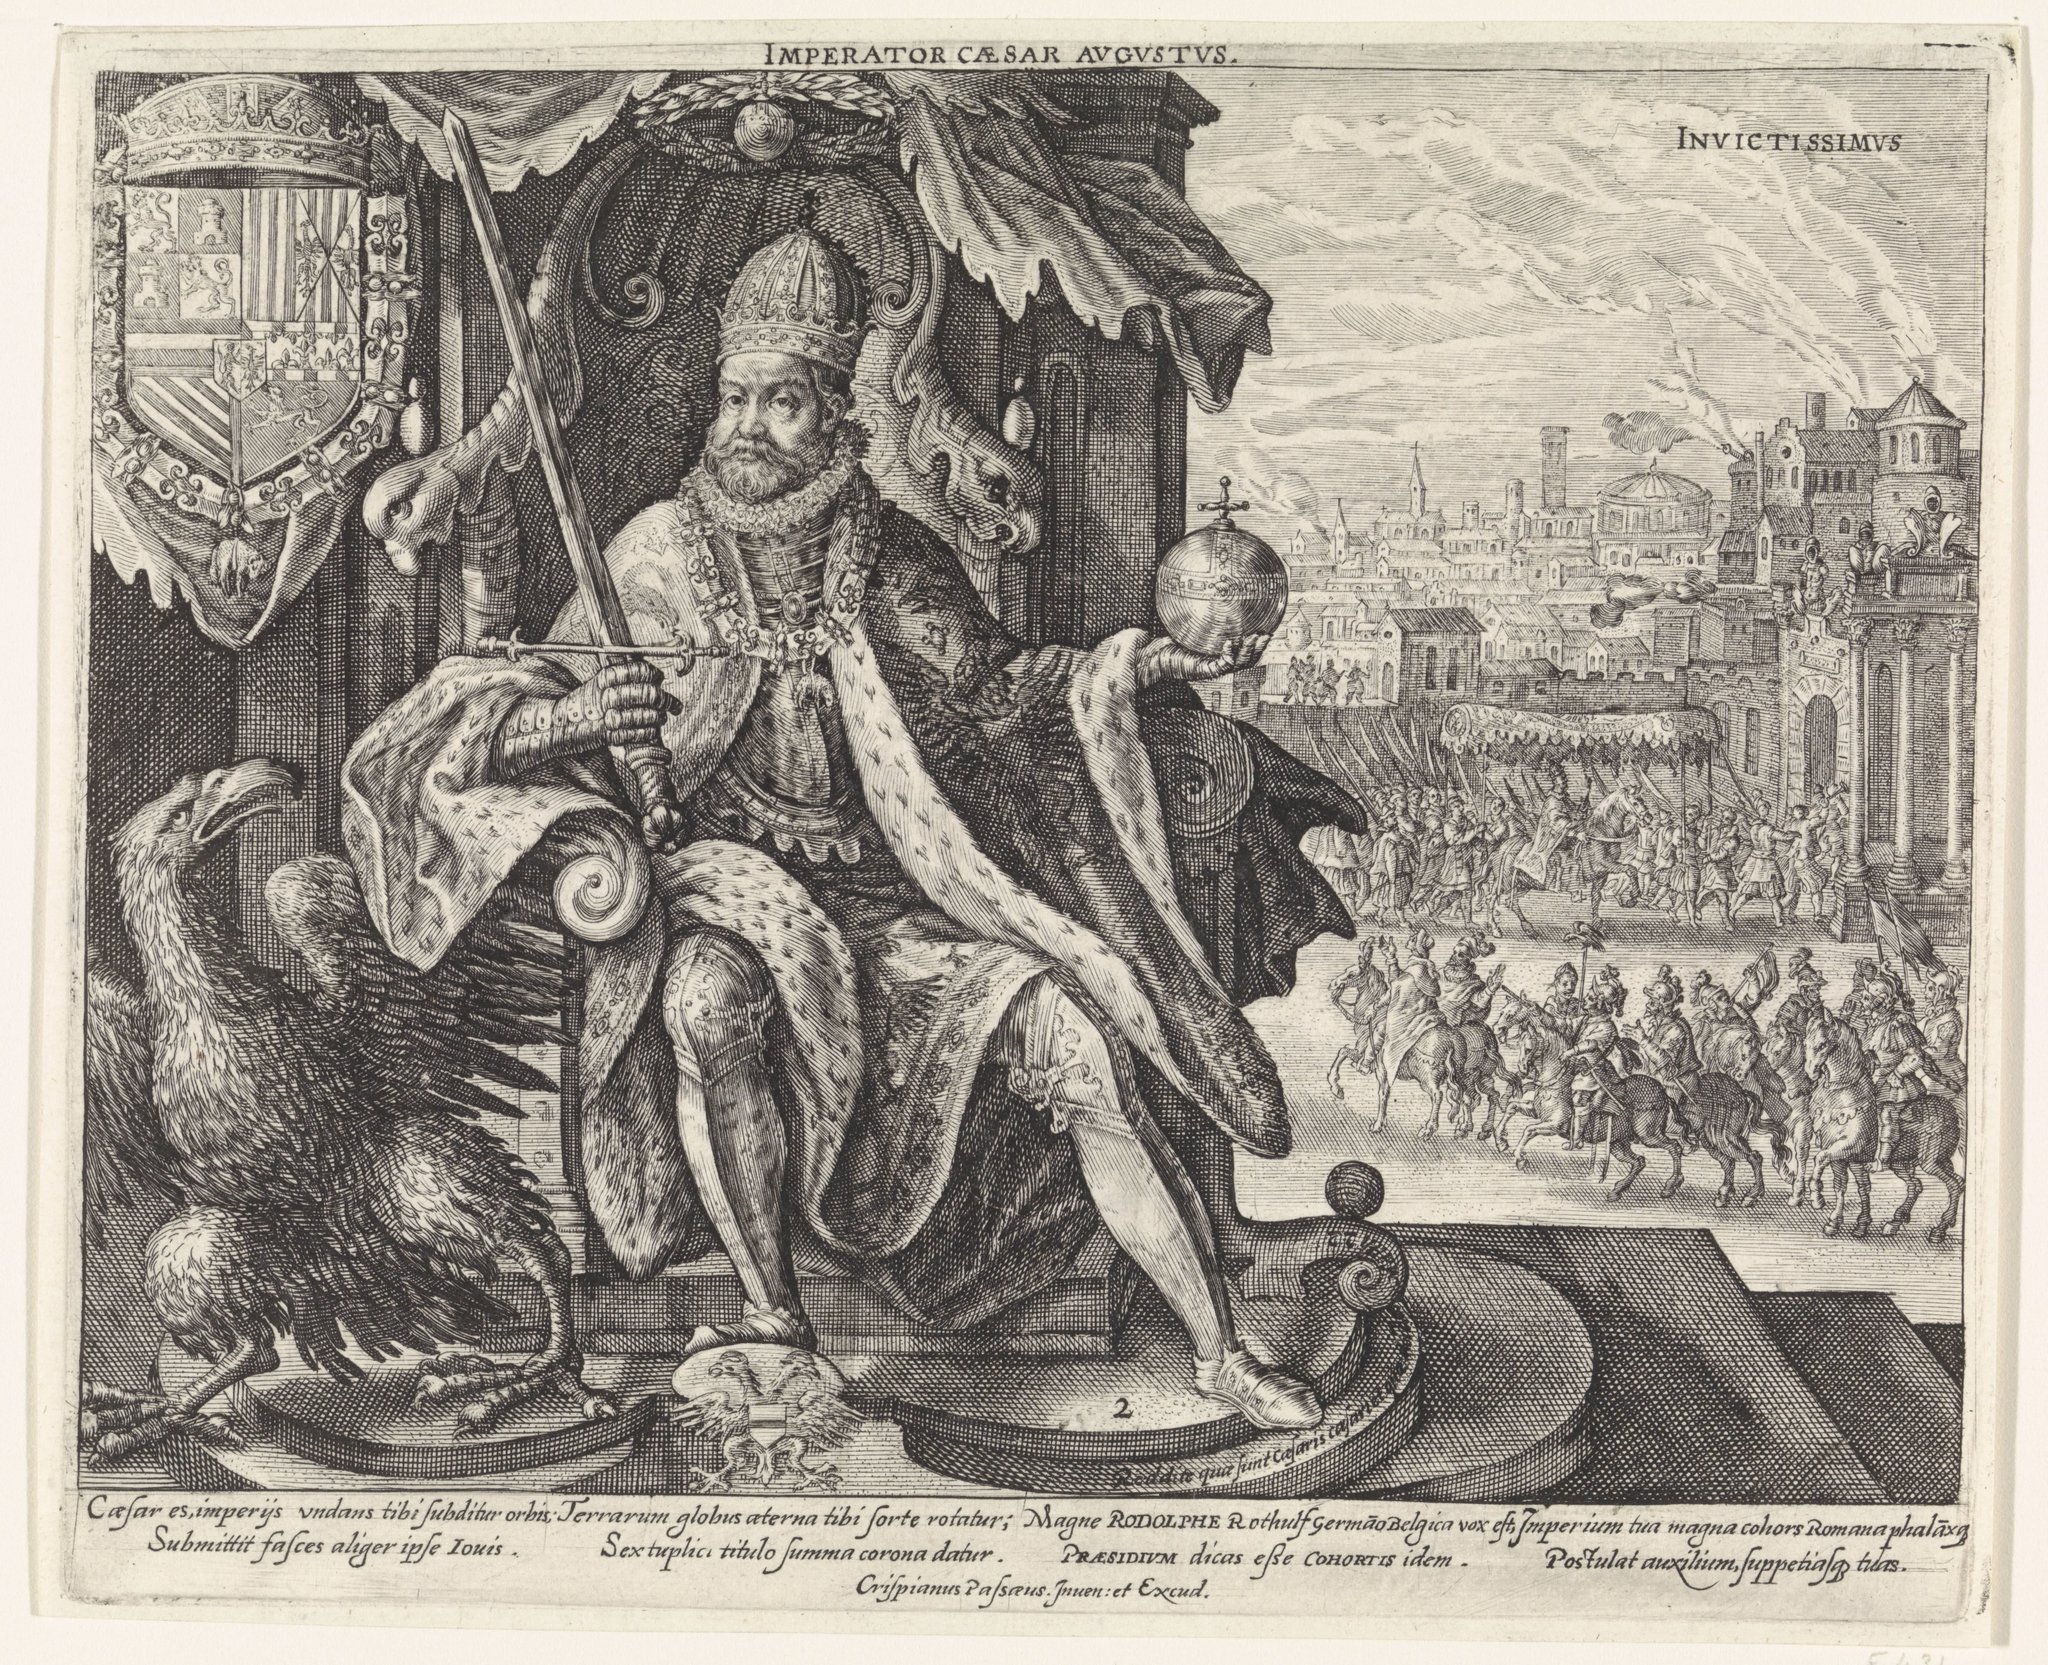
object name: print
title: Rudolf II van Habsburg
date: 1611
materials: paper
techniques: engraving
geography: utrecht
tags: vienna, prague, rudolf ii van habsburg (duits keizer), sceptre, staff (symbol of sovereignty), triumphal entry and public reception, pageant, 'entrée solennelle', 'joyeuse entrée', throne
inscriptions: collector's mark: Lugt 2542, collector's mark: Lugt 2228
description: Rudolf II van Habsburg op een troon onder een lauwerkrans. In zijn linkerhand houdt hij een rijksappel en in zijn rechterhand een zwaard. Naast hem zijn wapenschild. Linksonder een adelaar. Op de achtergrond de feestelijke intocht van Rudolf II van Habsburg. Midden onder een Bijbelcitaat uit Matt. 12 in het Latijn. In de marge een achtregelig lofdicht, in vier kolommen, in het Latijn. Tweede prent uit een serie van vier met wereldheersers.